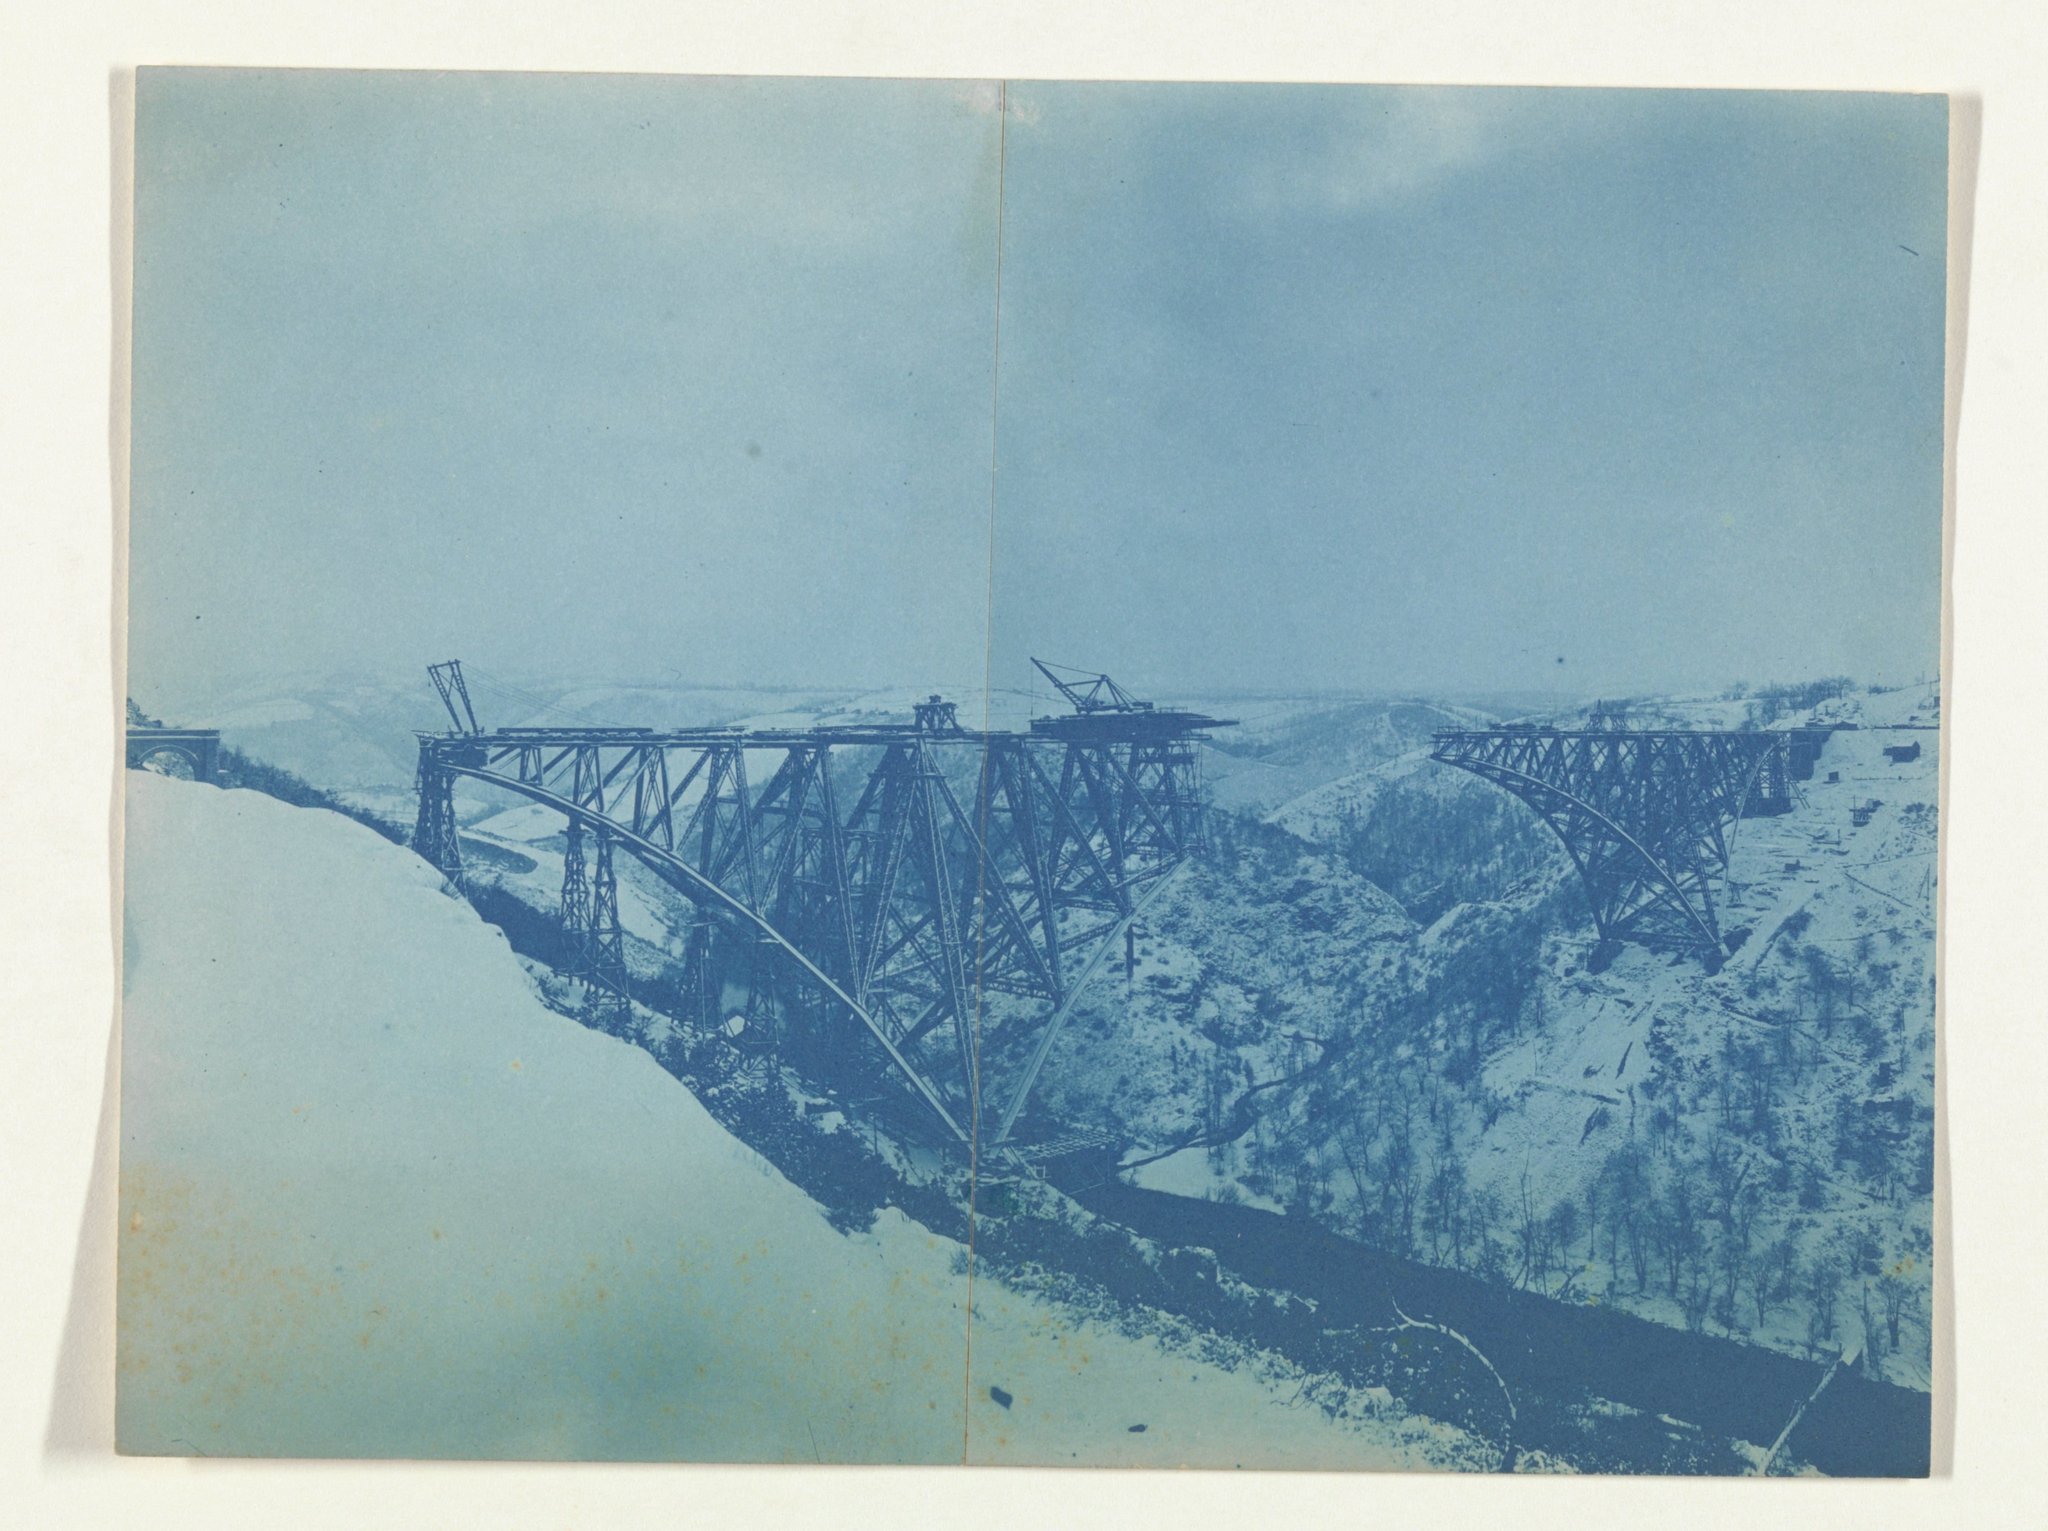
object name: photograph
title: Aanleg van het Viaur Viaduct in Frankrijk door de Societé de Construction des Battignolles, 2 februari 1902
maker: Anonymous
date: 1902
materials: photographic support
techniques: cyanotype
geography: france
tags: viaduct, making the overground structures (~ building activities)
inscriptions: date